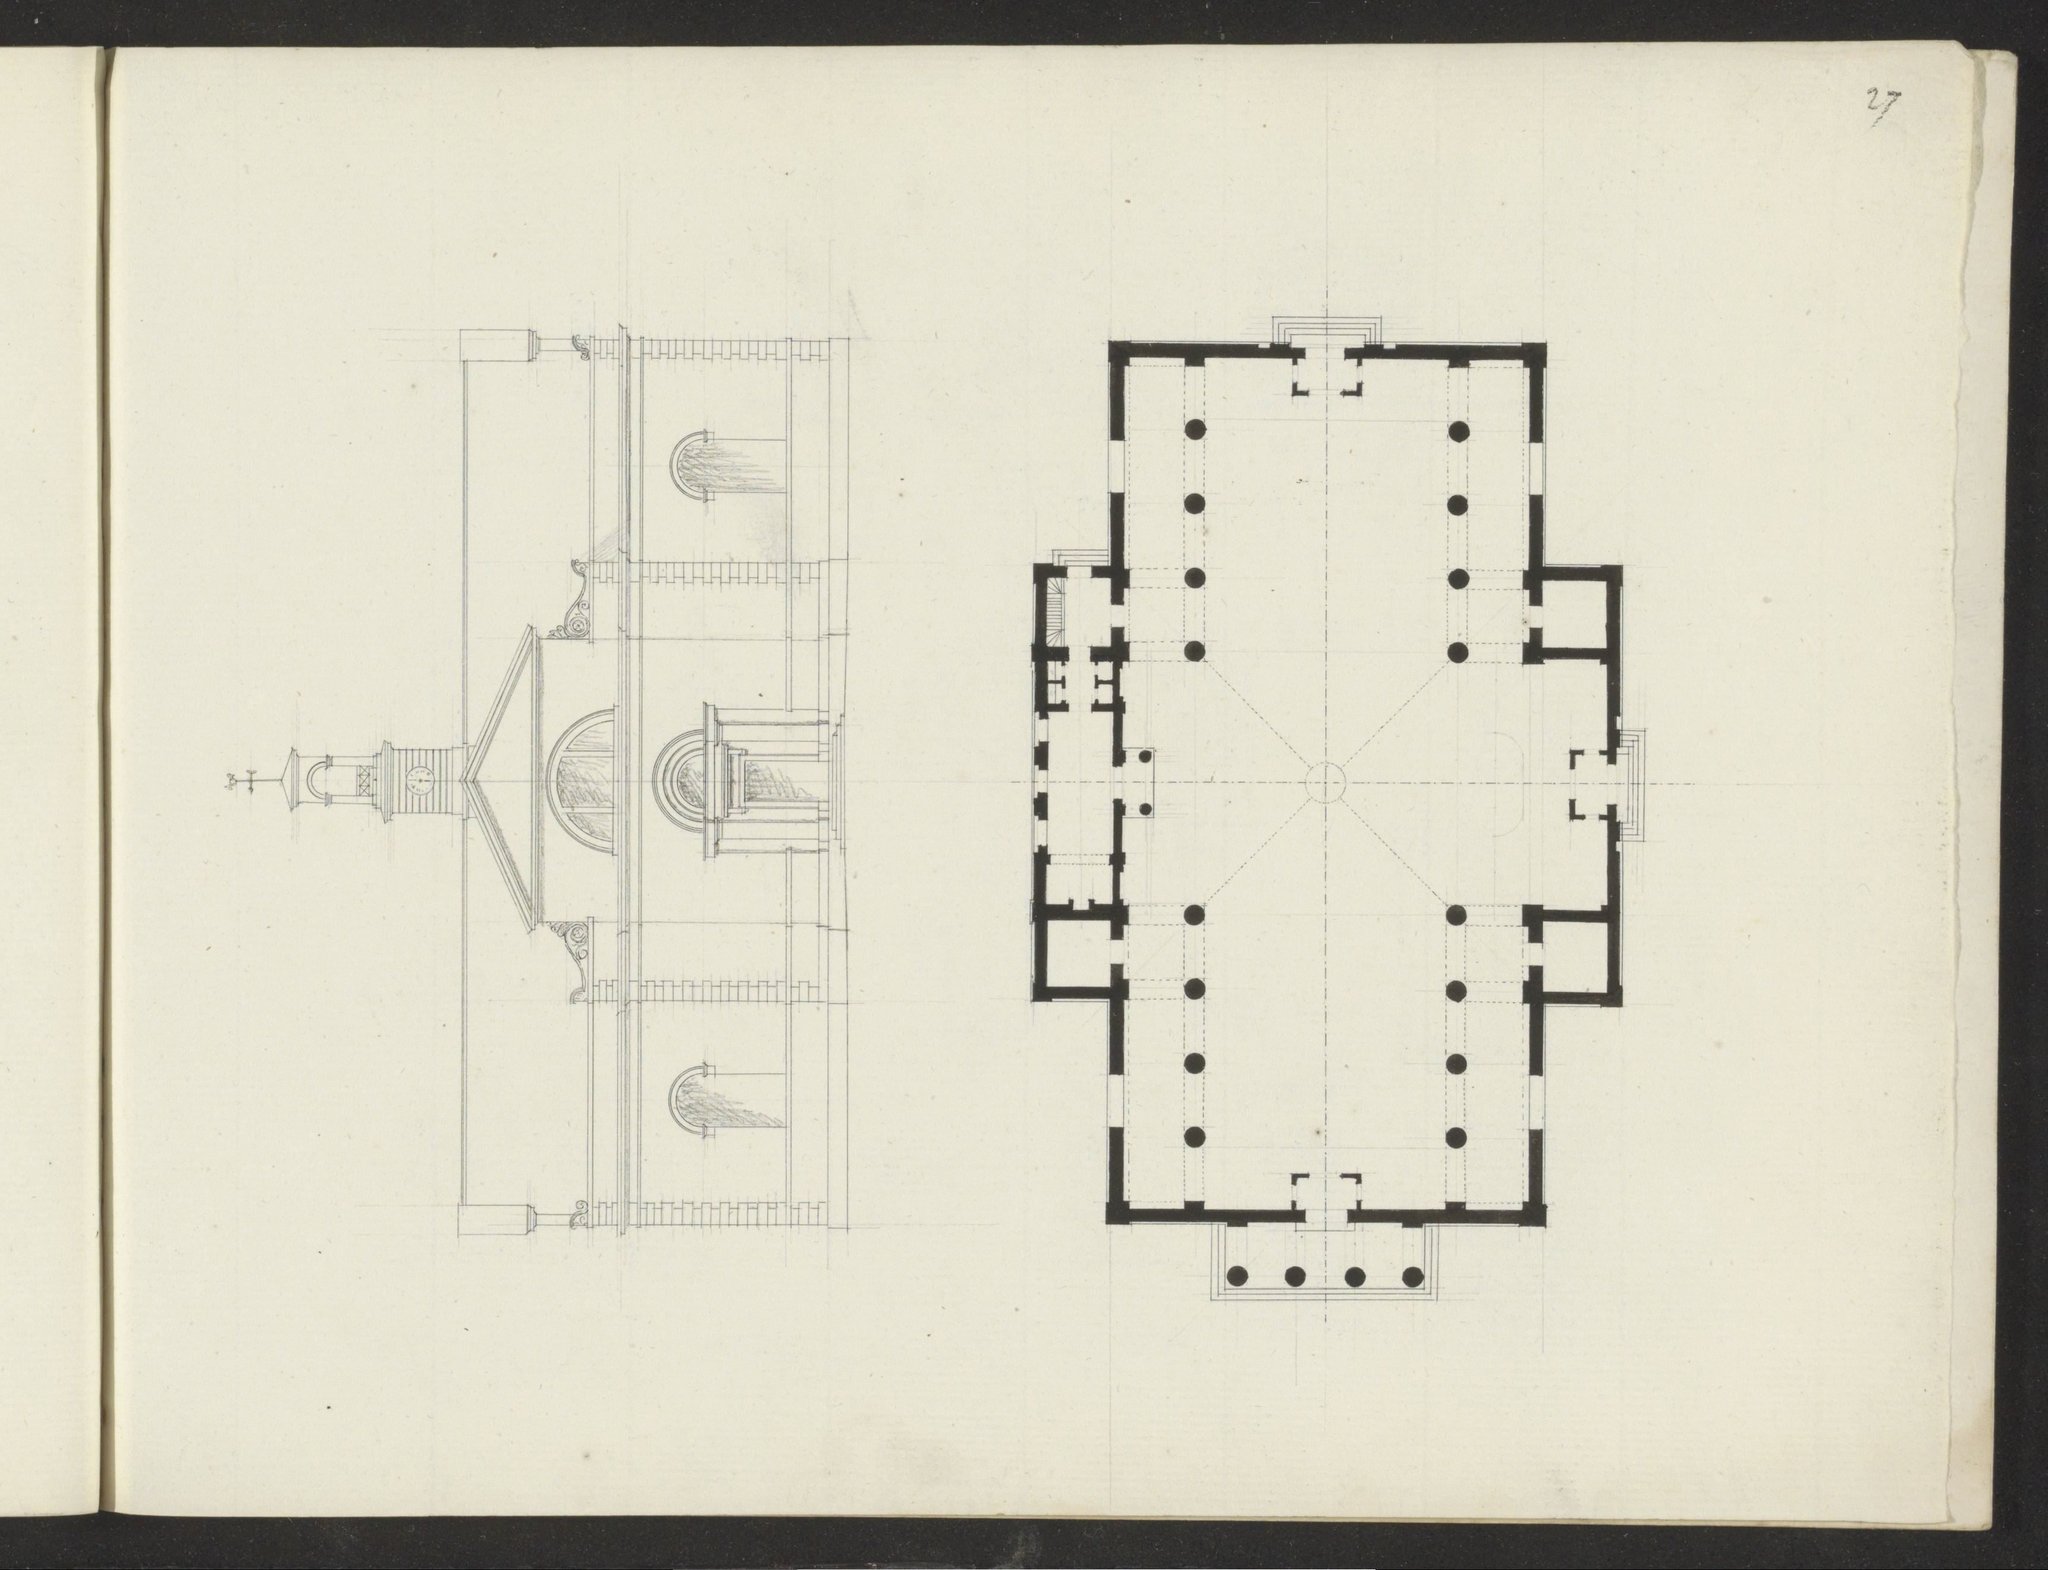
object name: sketchbook leaf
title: Plattegrond en voorgevel van een gebouw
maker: willem springer jr.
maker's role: draughtsman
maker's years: 1815-1907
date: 1825-1907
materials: ink, paper, pencil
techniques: pen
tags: façade (of house or building), plan ~ architecture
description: Pagina 27 uit een schetsboek met 28 pagina's.